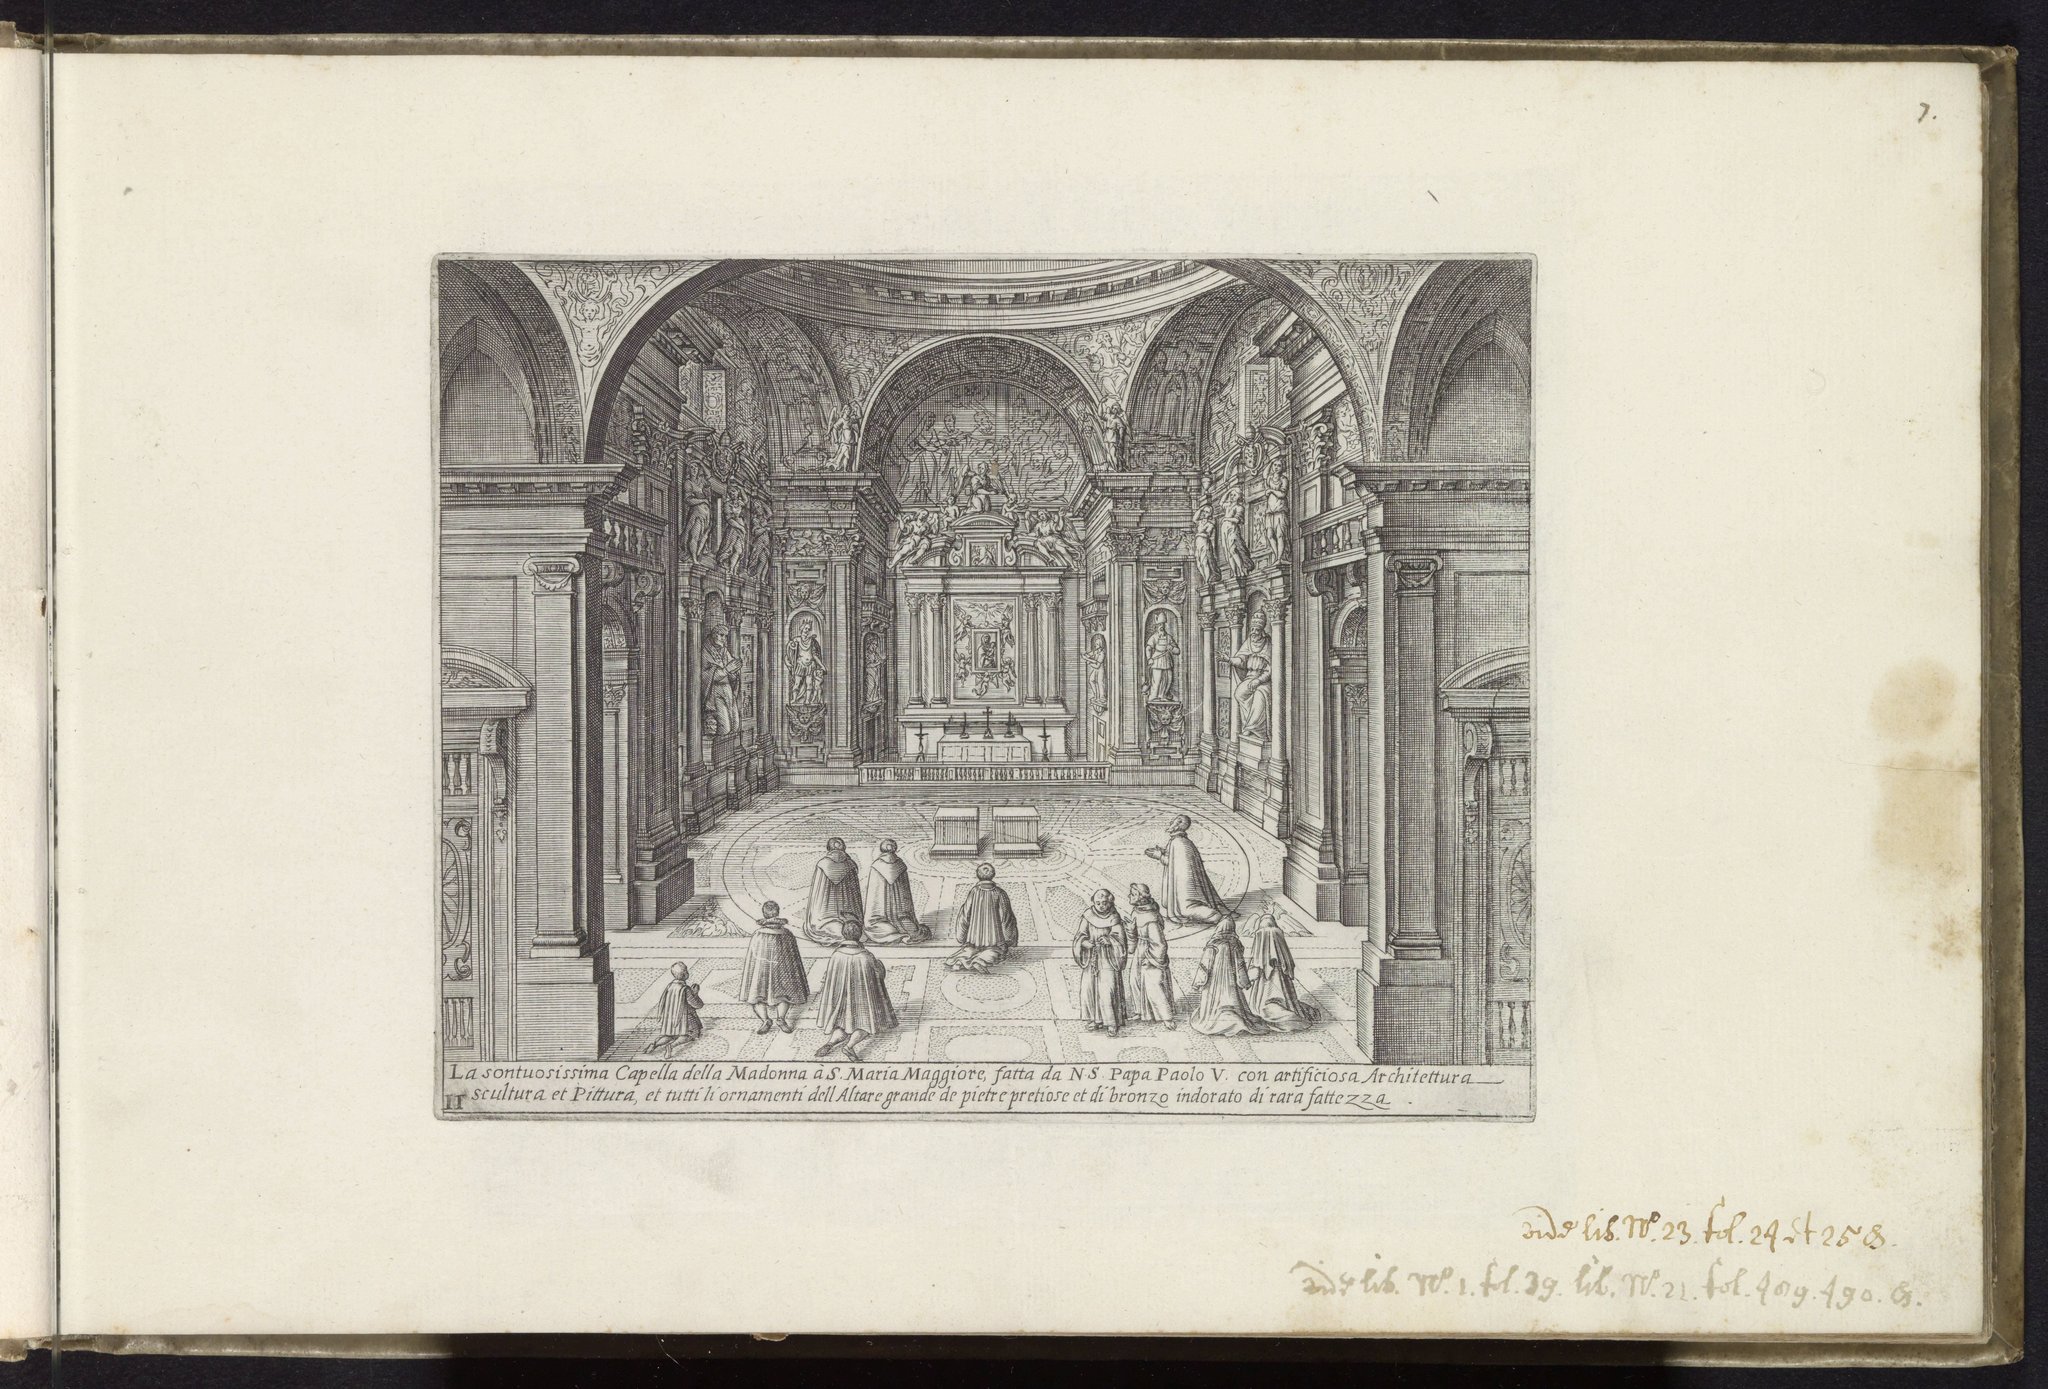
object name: print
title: Cappella Paolina in de Santa Maria Maggiore te Rome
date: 1618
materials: paper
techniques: engraving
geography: rome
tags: interior of church, parts of church interior: chapel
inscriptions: inscription: ‘Ende lib. No. 23. fol. 24 et 258/ Ende lib. No. 1. fol. 39. lib. No. 21. fol. 489. 490. 8.’, number: ‘7’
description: Gezicht in de Cappella Paolina in de Santa Maria Maggiore te Rome. Geestelijken knielen in de kapel. Titel in het Italiaans in ondermarge. Prent maakt deel uit van een album.